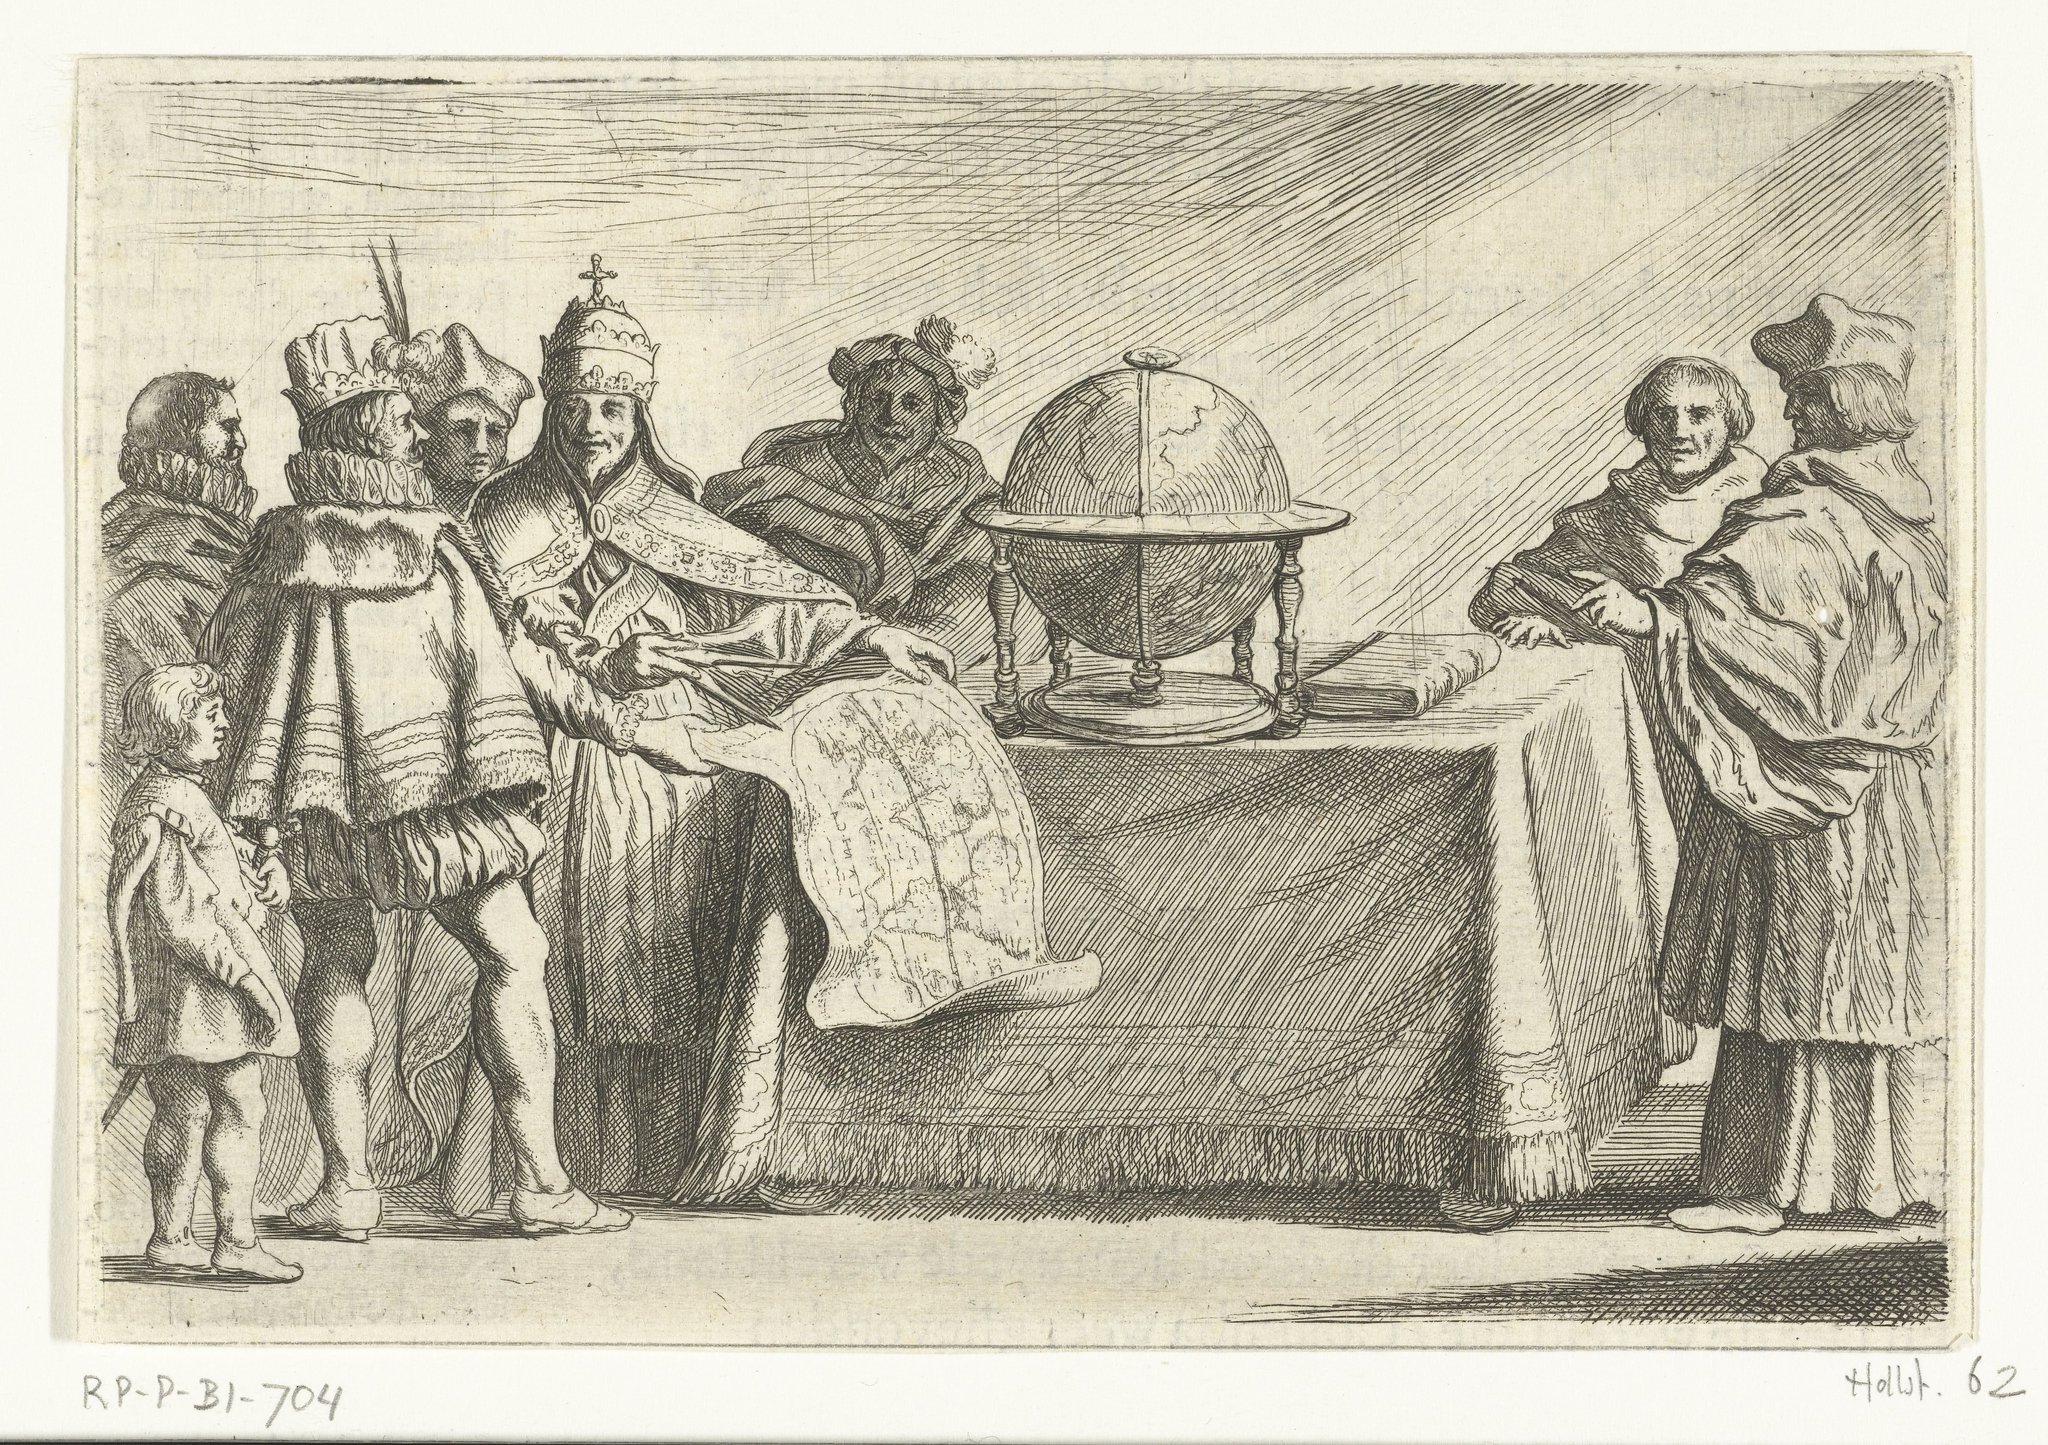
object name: print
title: Columbus bij de paus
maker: willem basse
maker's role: draughtsman, print maker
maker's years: 1613-1672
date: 1632-1634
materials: paper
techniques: engraving, etching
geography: northern netherlands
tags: genua, valladolid, ontdekkingsreiziger, zeevaarder, christoffel columbus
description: Christoffel Columbus en de paus overleggen bij kaart van de wereld, bij een tafel waarop een globe. Ook andere geleerden zijn hierbij aanwezig, ca. 1500. Bedrukt op achterzijde met tekst in het Nederlands.